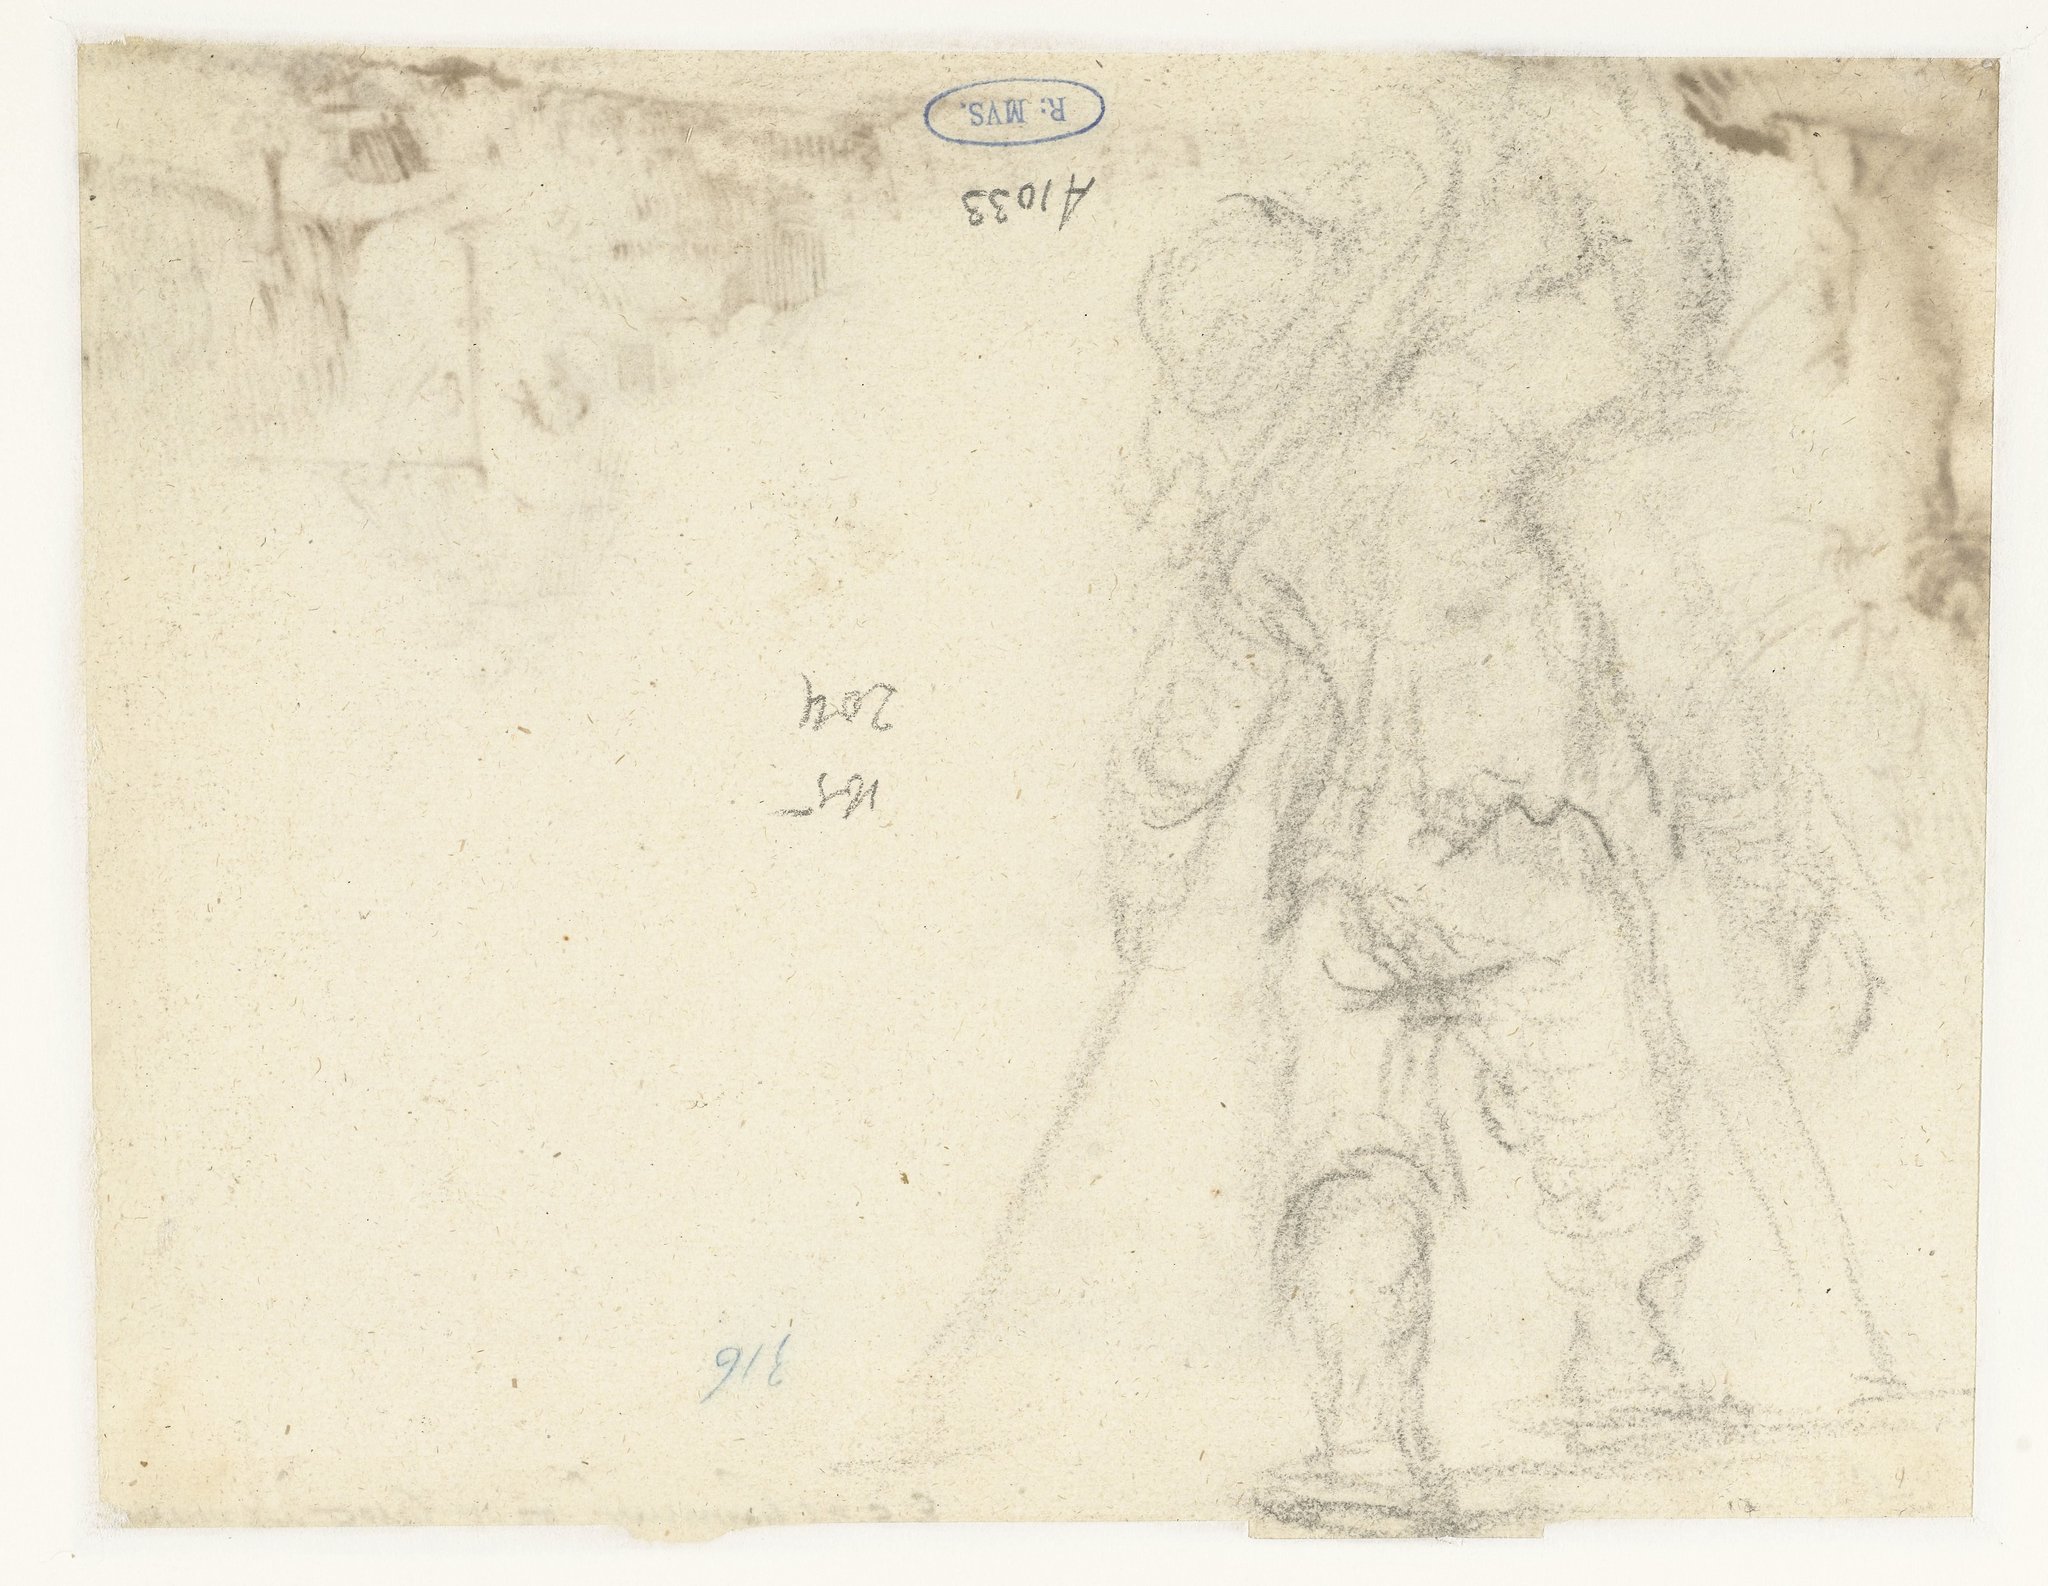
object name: drawing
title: Jongen, van achteren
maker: harmen ter borch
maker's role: draughtsman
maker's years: 1638-1677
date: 1653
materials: chalk, paper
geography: zwolle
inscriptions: date